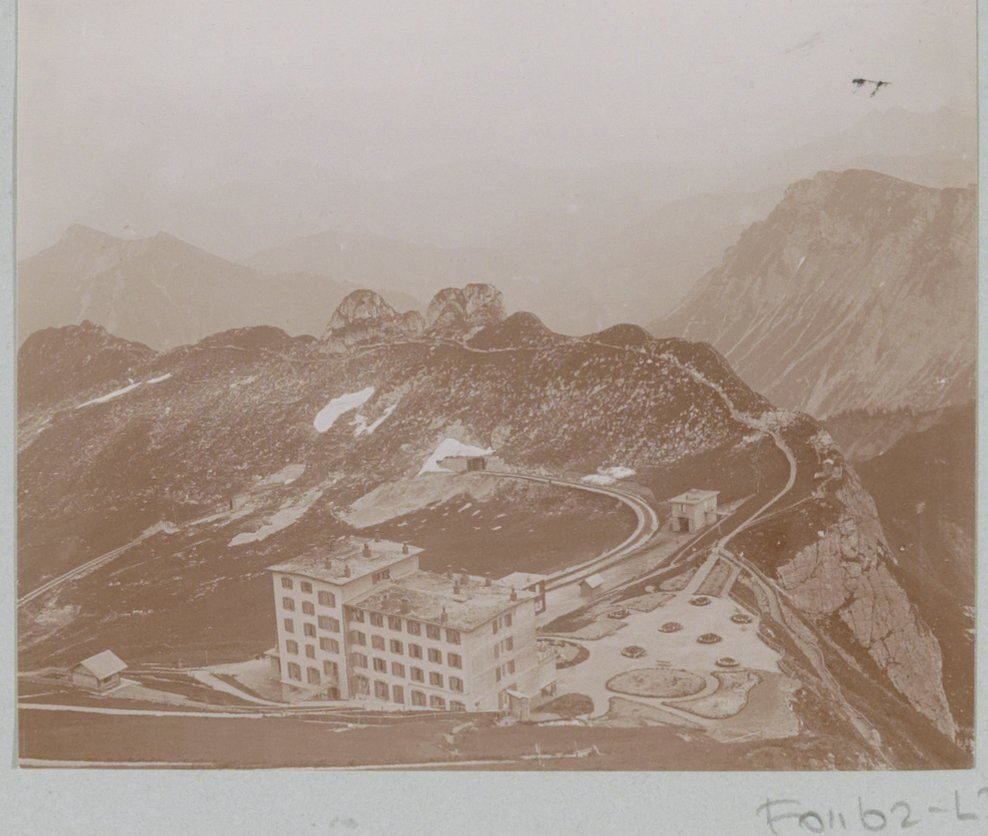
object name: photograph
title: Berglandschap met Grand Hotel Rochers de Naye, spoorlijn en paden in de Zwitserse Alpen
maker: Anonymous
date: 1905-1910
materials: paper, photographic support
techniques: gelatin silver print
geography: rochers de naye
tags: railway, train, mountains (+ landscape with figures, staffage), hotel, hostelry, inn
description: Onderdeel van Fotoalbum van een Franse amateurfotograaf met bezienswaardigheden in Frankrijk, Zwitserland en Italië.